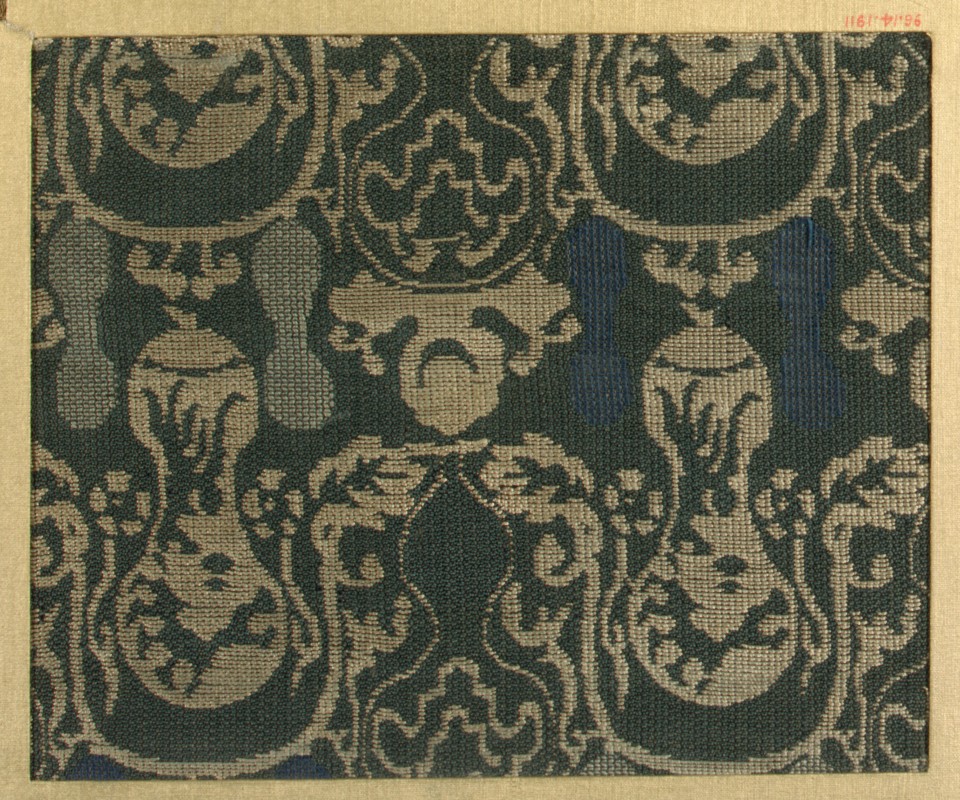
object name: piece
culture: japanese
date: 1701-1900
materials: silk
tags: gourds